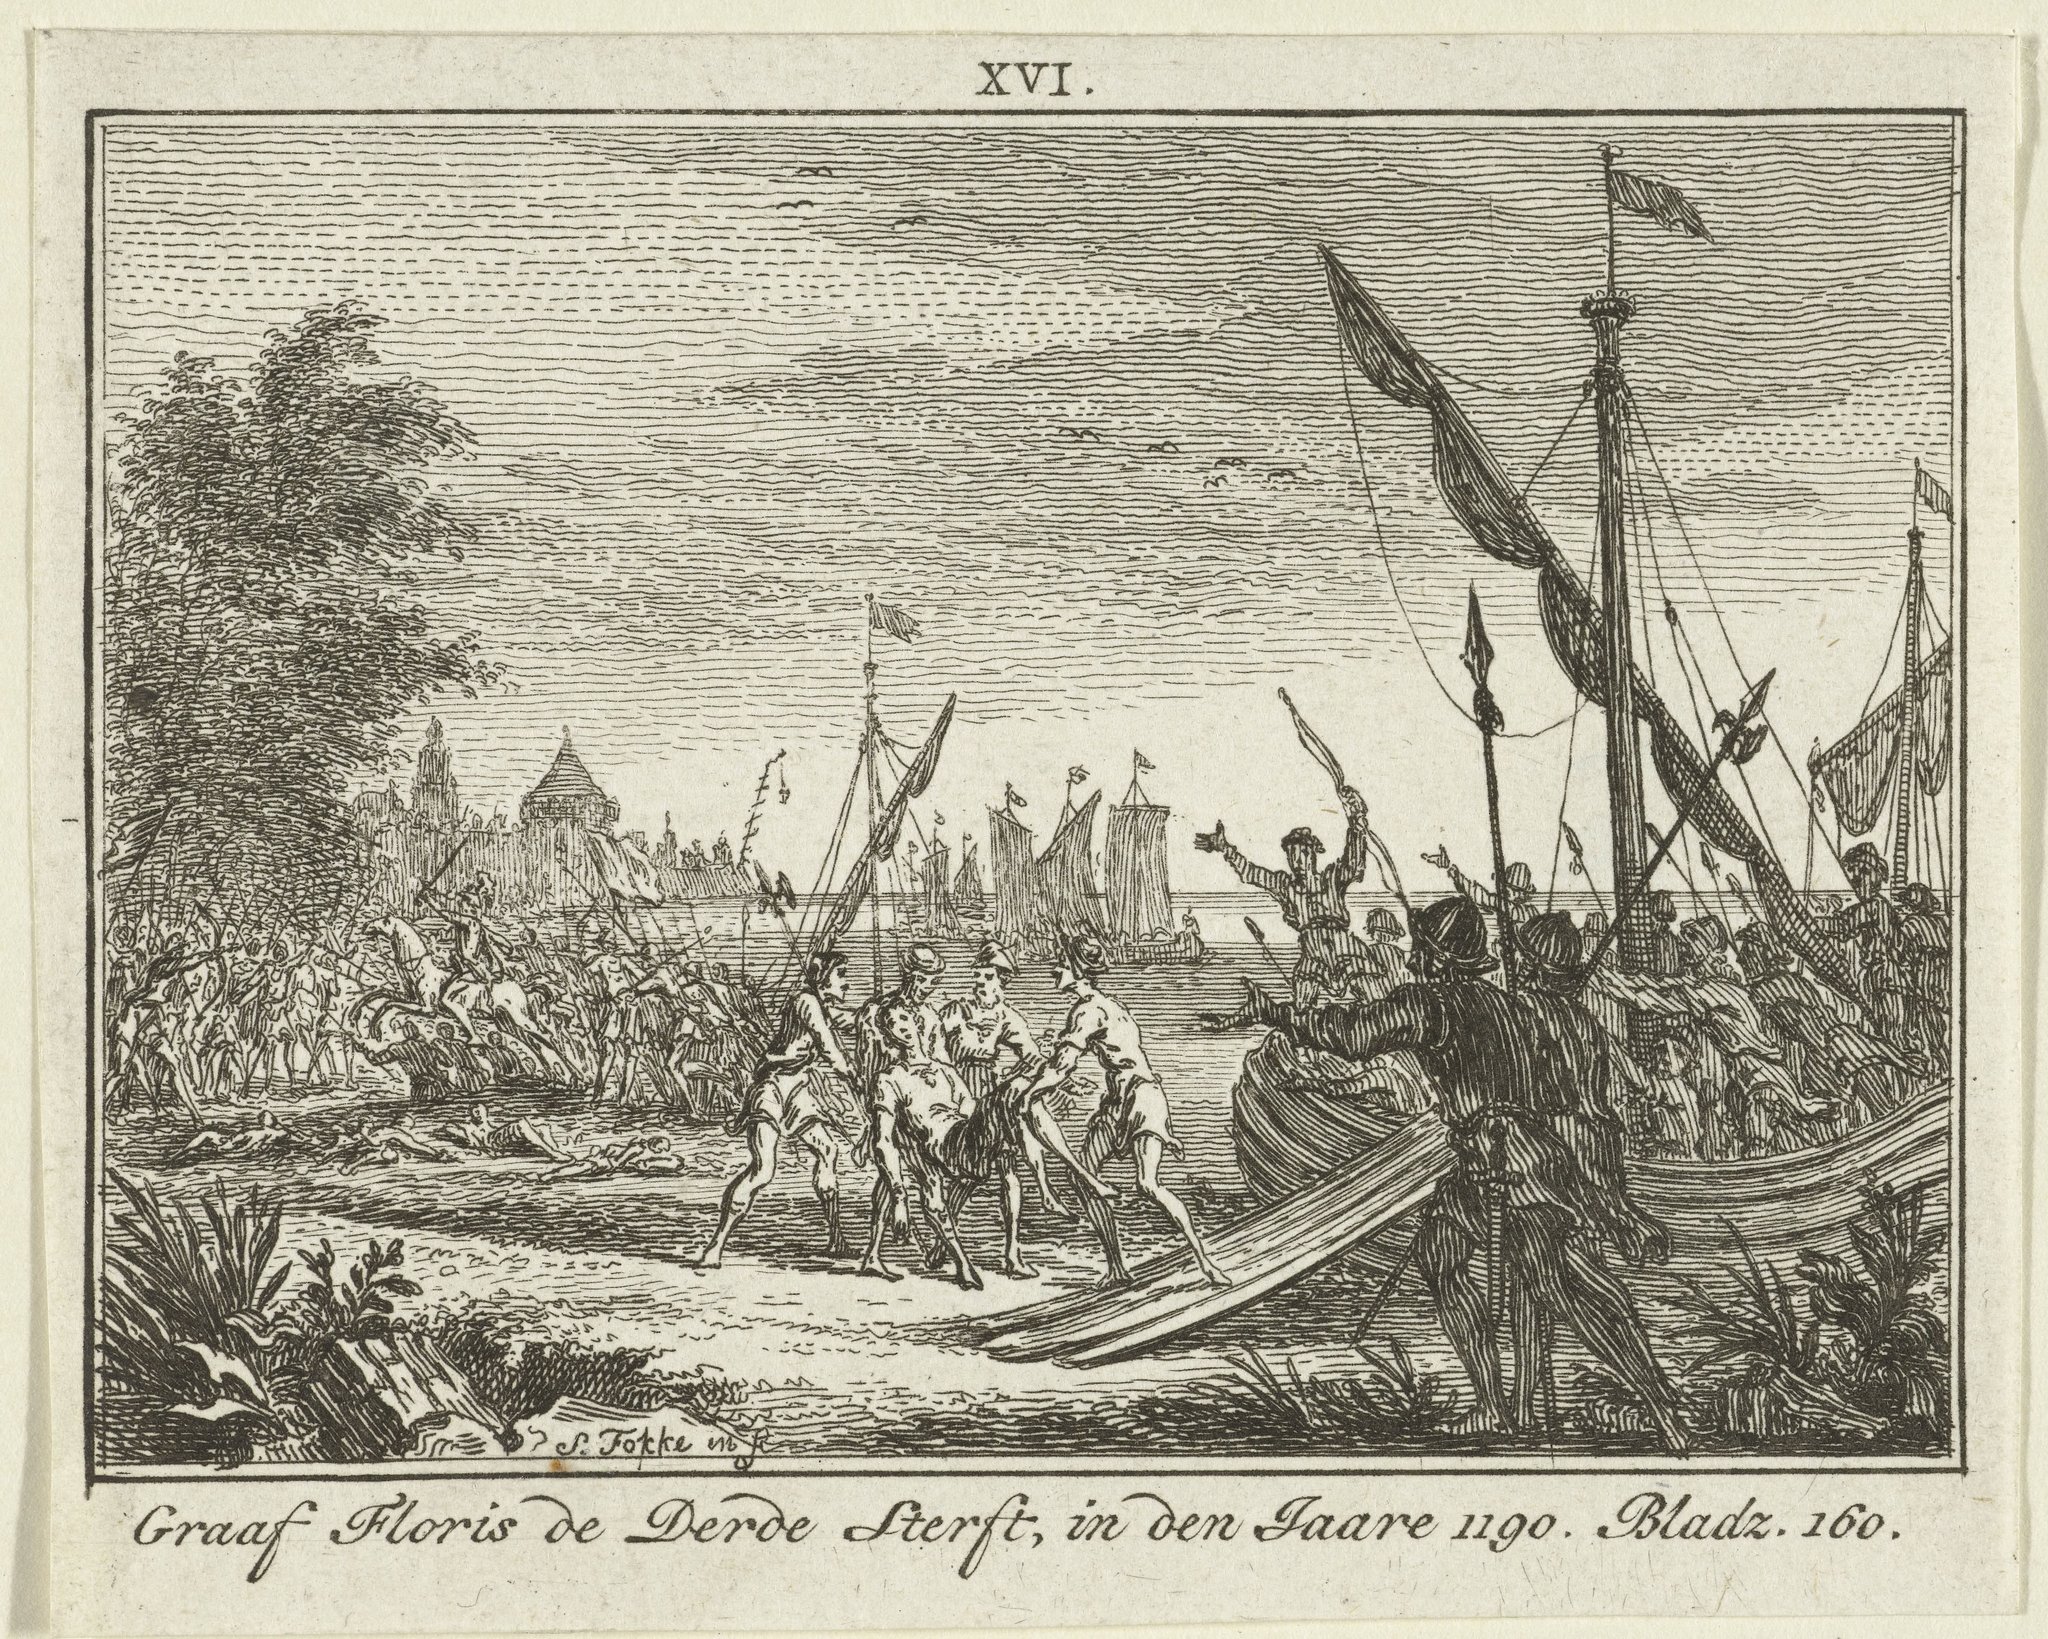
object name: print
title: Dood van Floris III, 1190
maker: simon fokke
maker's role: draughtsman, print maker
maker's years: 1712-1784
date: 1722-1750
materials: paper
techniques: etching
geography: northern netherlands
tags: dying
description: Illustratie voor een onbekend werk, later hergebruikt in: J.W. te Water, De vaderlandsche Historie van den heere J. Wagenaar, verkort, en met leerzaame aanmerkingen, ten dienste der Nederlandsche jeugd, 1784-1800, 4 delen, pl. XVI, blz. 160.